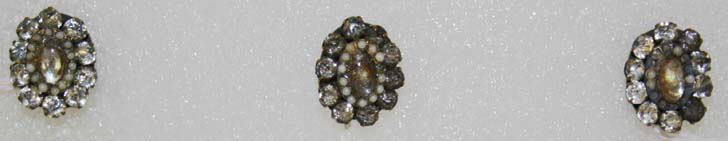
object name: button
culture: french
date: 1880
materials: paste